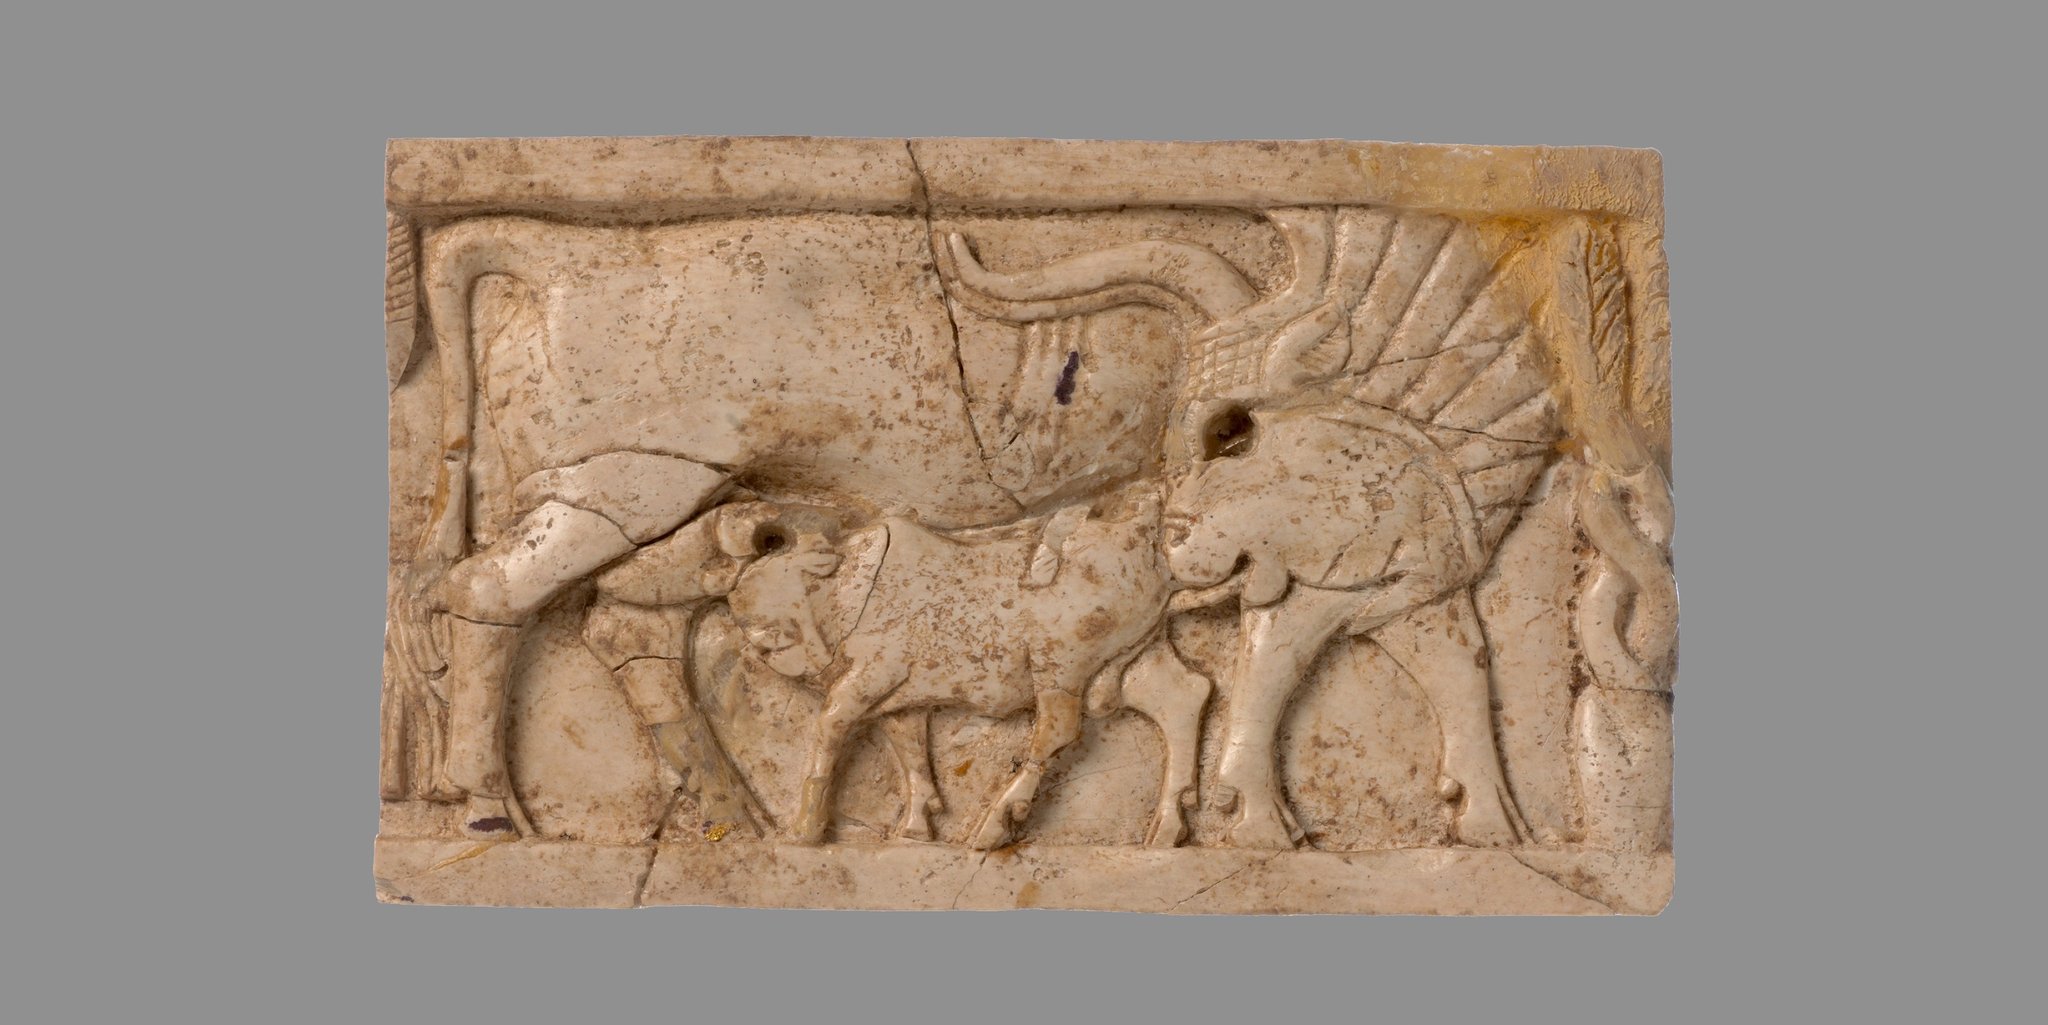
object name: relief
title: Furniture plaque carved in relief with a cow suckling a calf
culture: assyrian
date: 900-701 BCE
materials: ivory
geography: syria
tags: cows